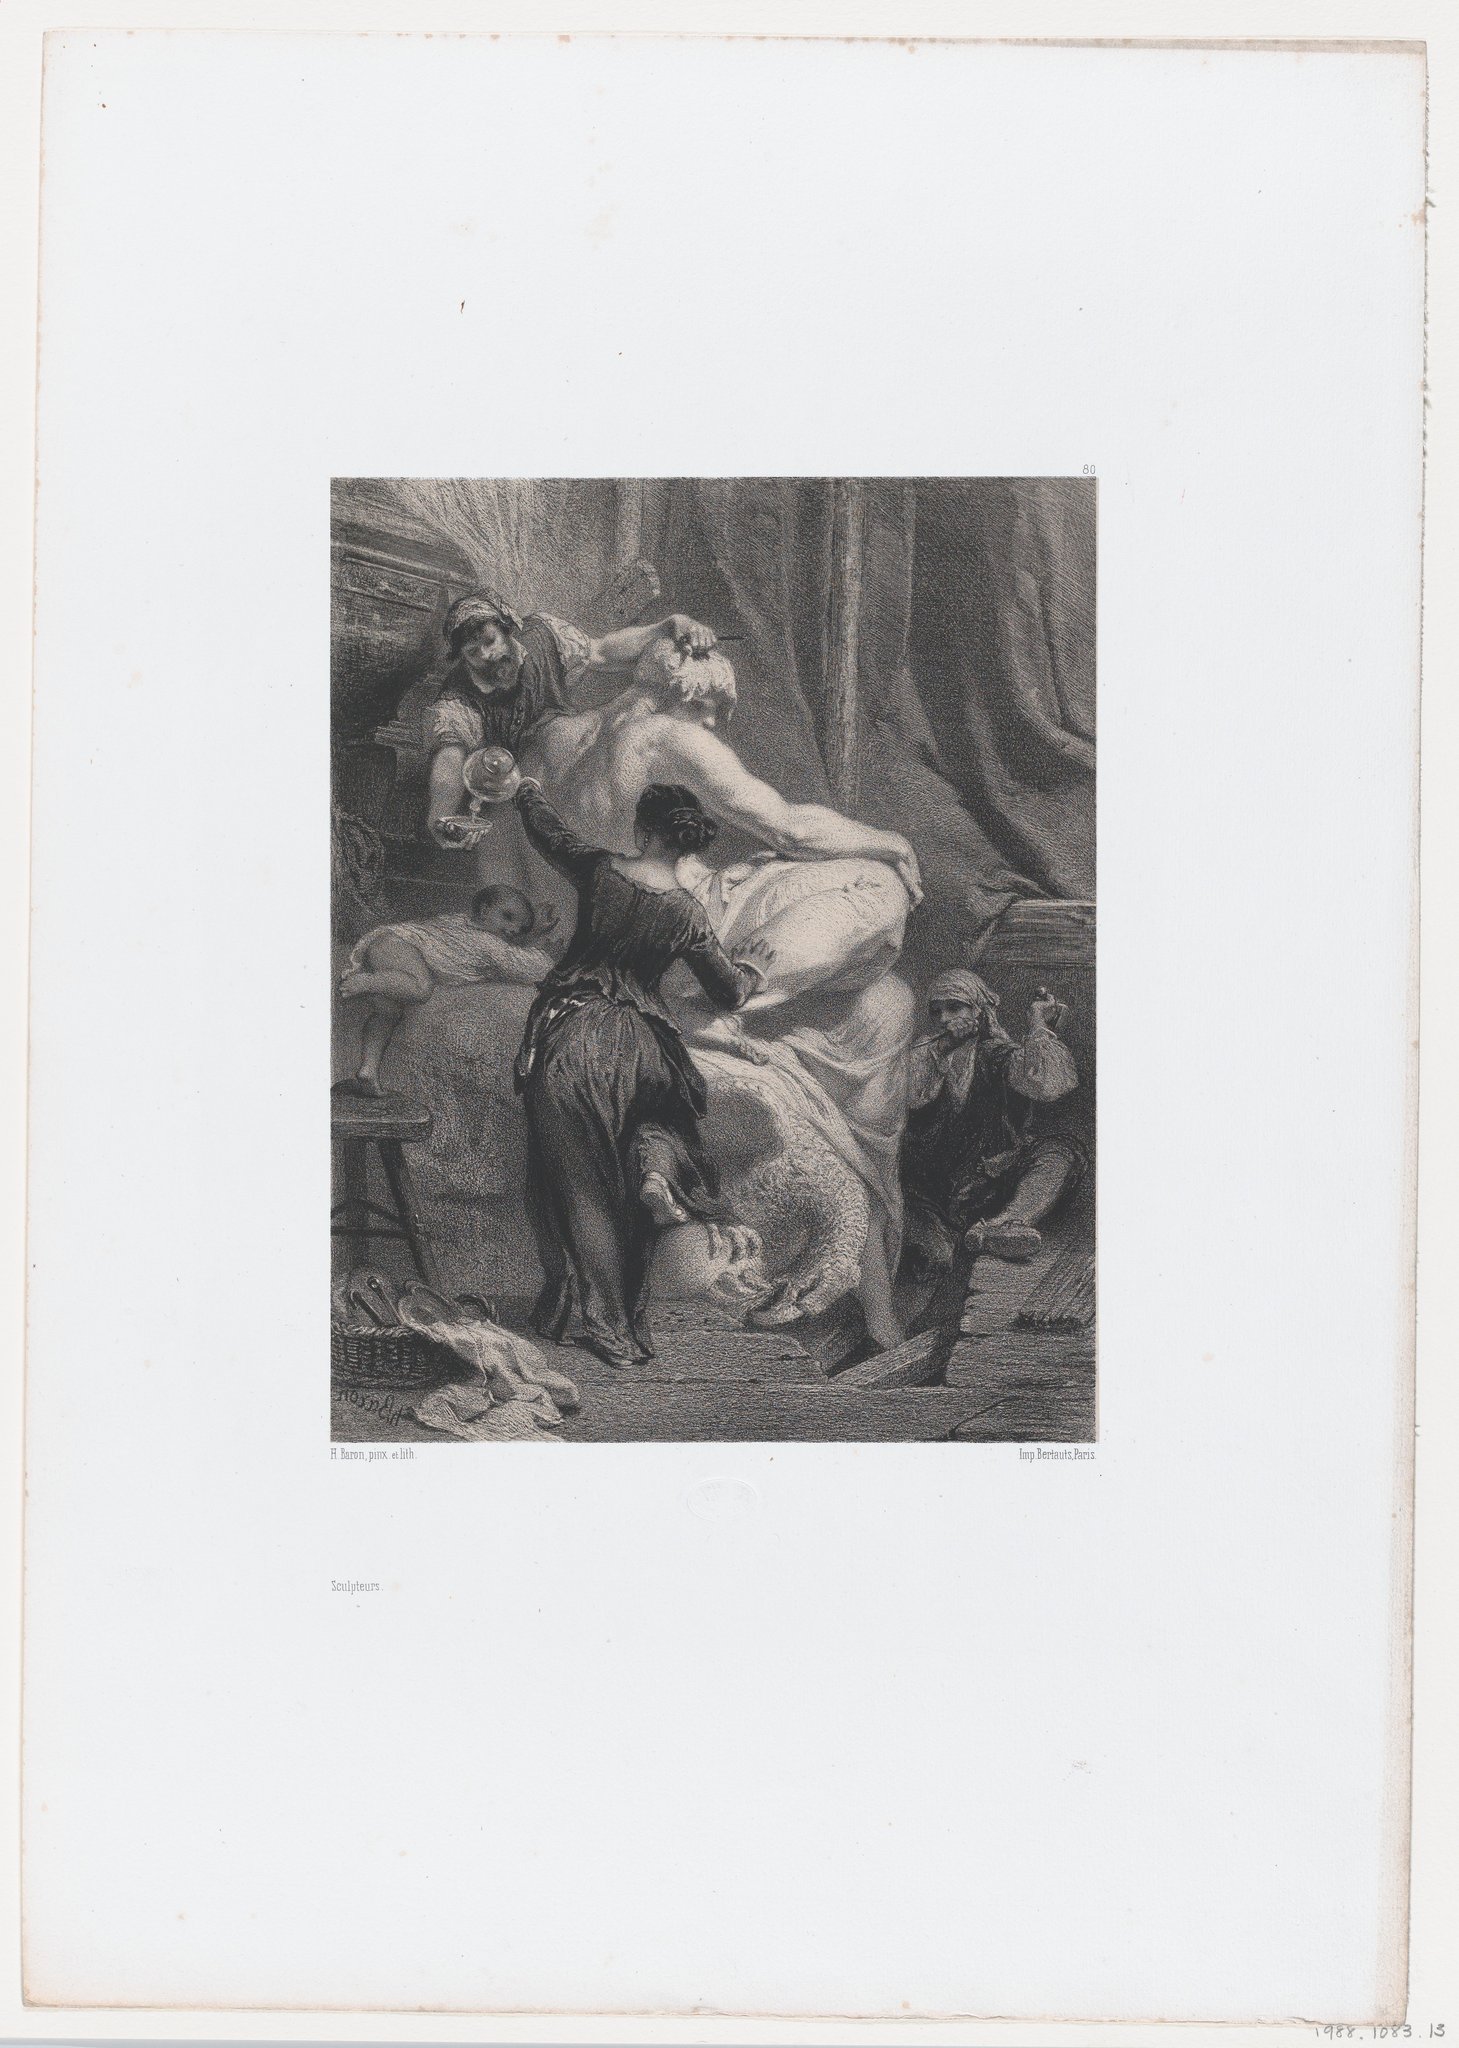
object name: print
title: The Sculptors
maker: henri-charles-antoine baron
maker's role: artist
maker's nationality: french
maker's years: 1816-1885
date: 1853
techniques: lithograph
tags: sculpture,children,men,women,artists